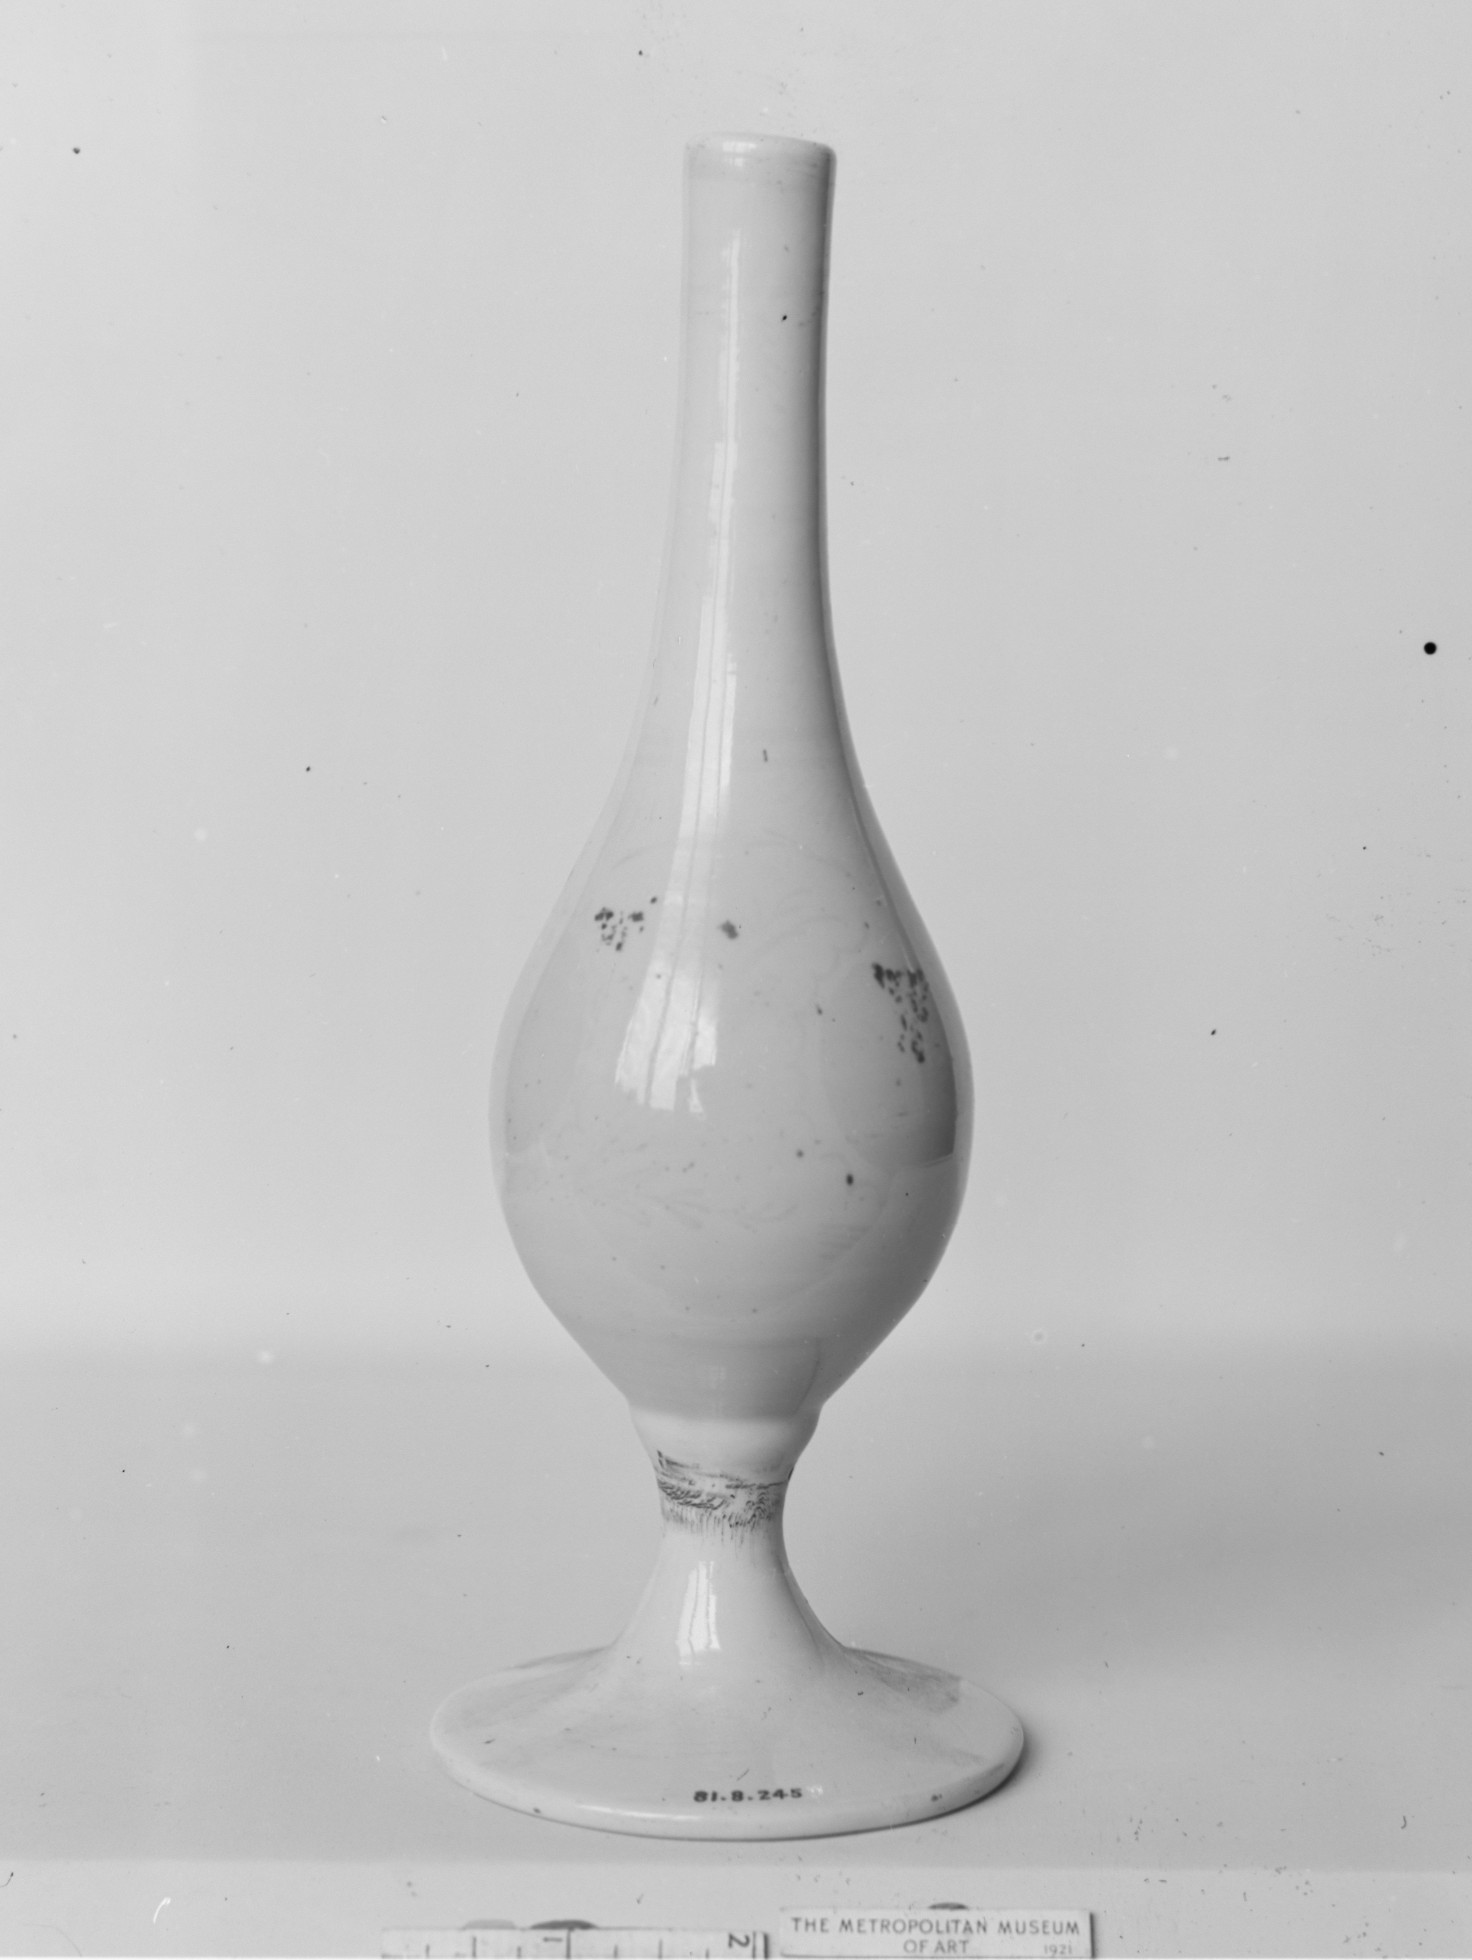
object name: vase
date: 1701-1800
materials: glass